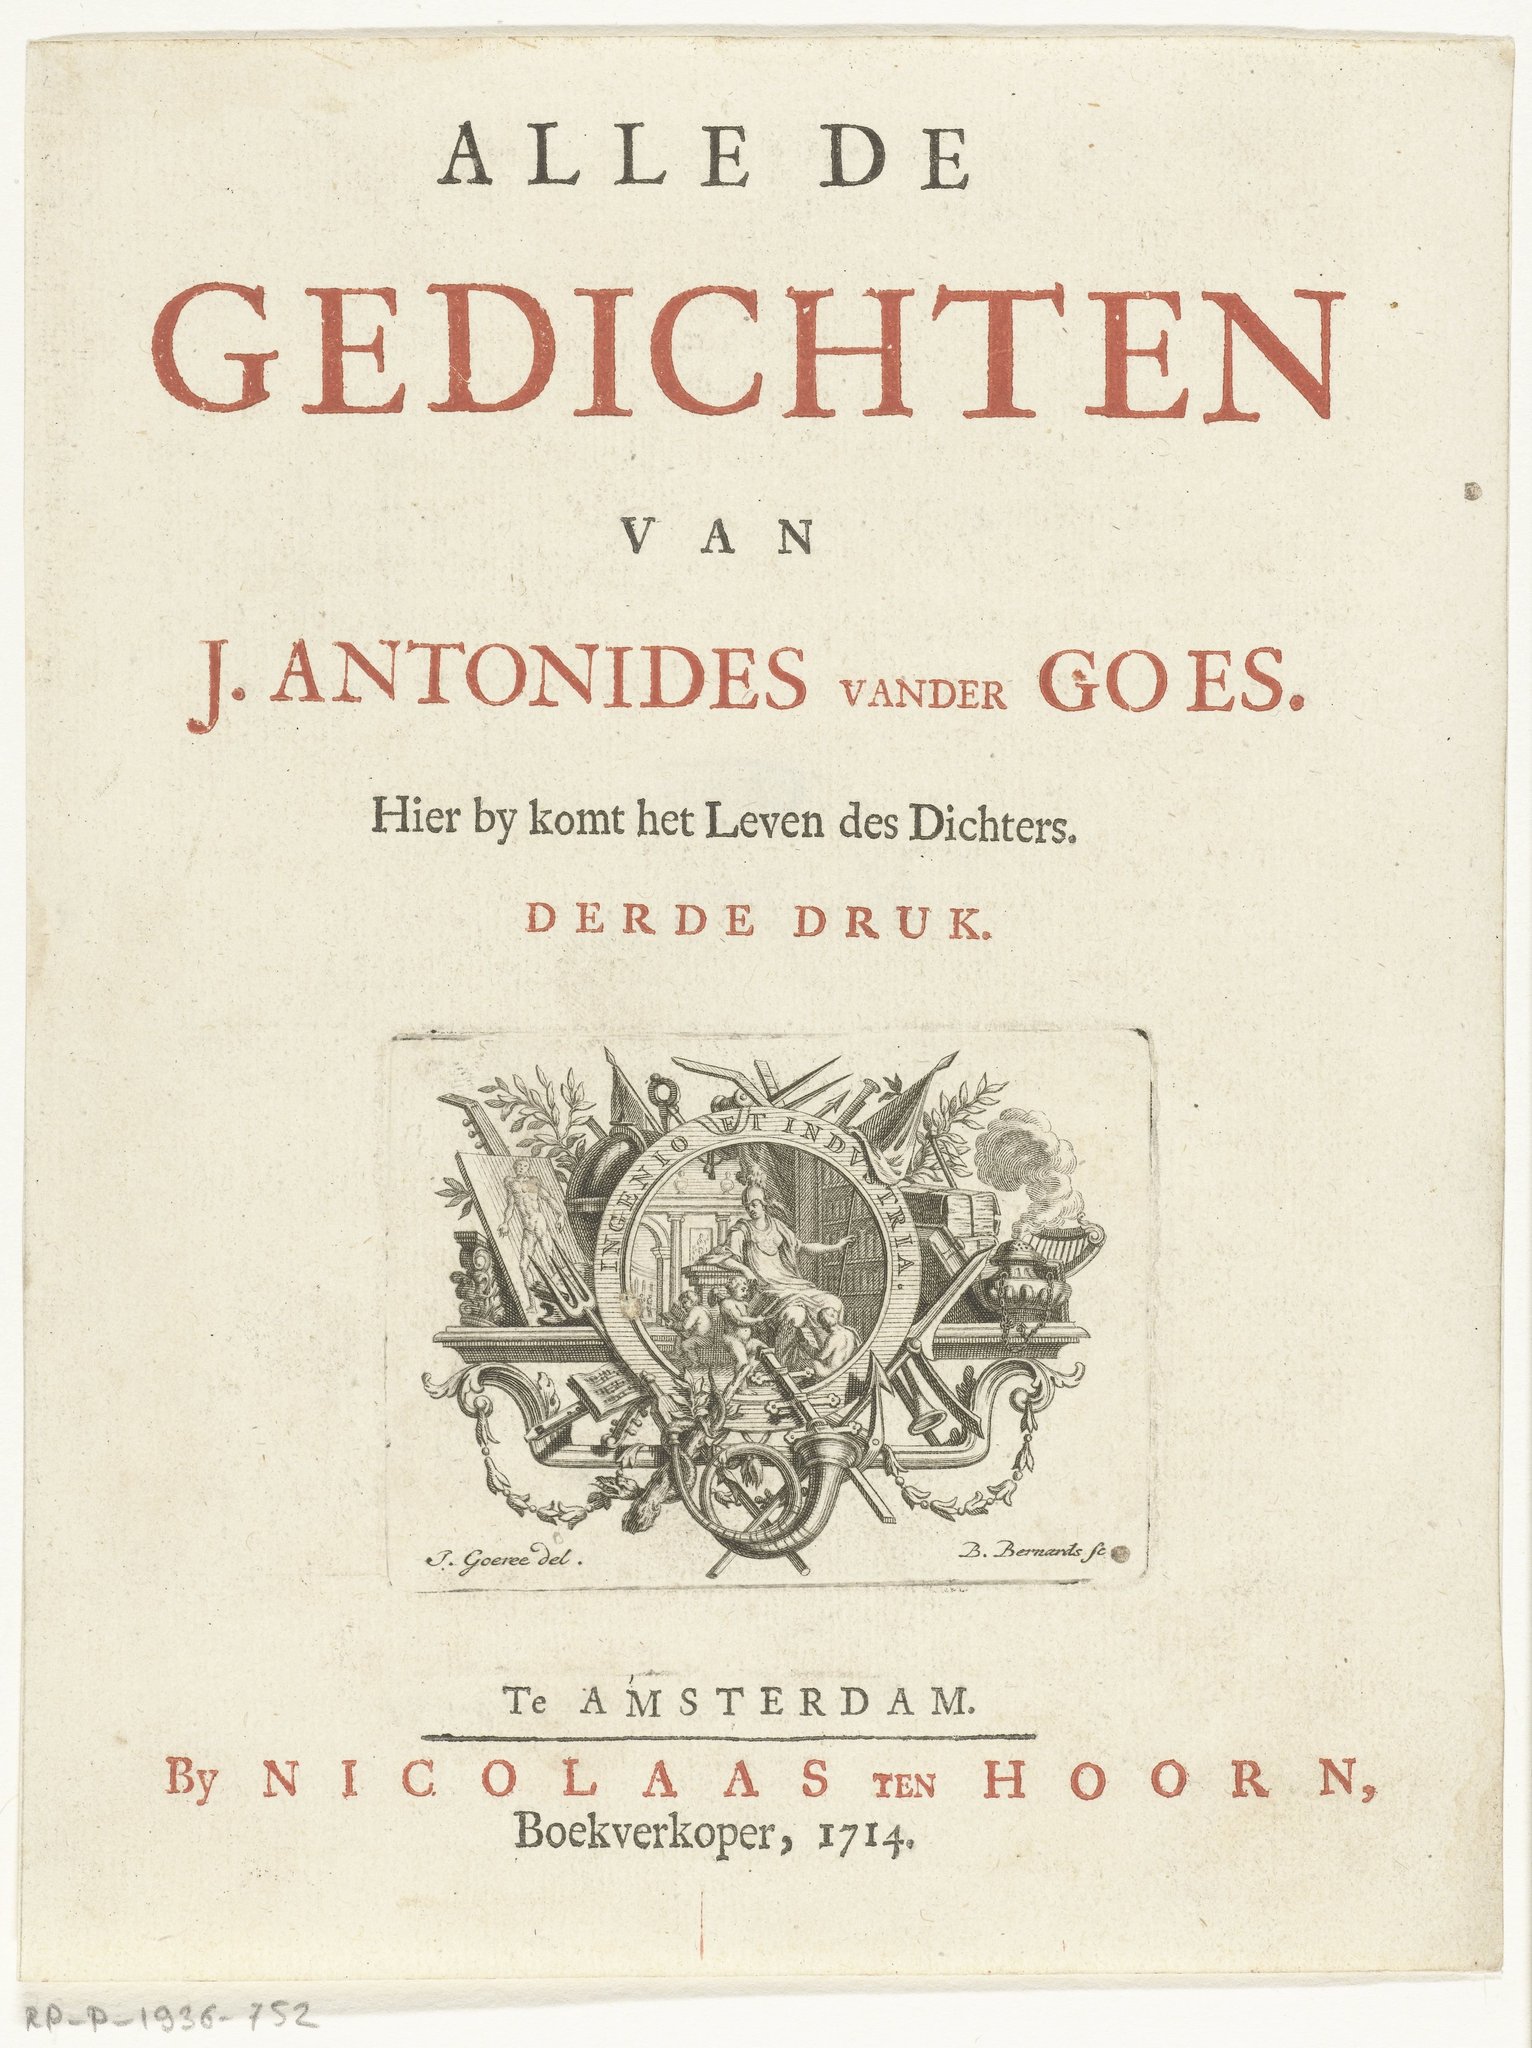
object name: print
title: Titelpagina voor "Alle de Gedichten van J. Antonides van der Goes". Amsterdam, 1714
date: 1714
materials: paper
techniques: engraving, letterpress printing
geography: amsterdam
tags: device (trade-mark of printer or publisher), armorial bearing, heraldry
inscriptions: collector's mark: Lugt 2228, collector's mark: Lugt 2760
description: Titelpagina met drukkersmerk van Nicolaas ten Hoorn met het motto: Ingenio et industria. In het midden een allegorische figuur met speer en helm en drie putti in een bibliotheek. Eromheen verschillende artistieke en wetenschappelijke symbolen.